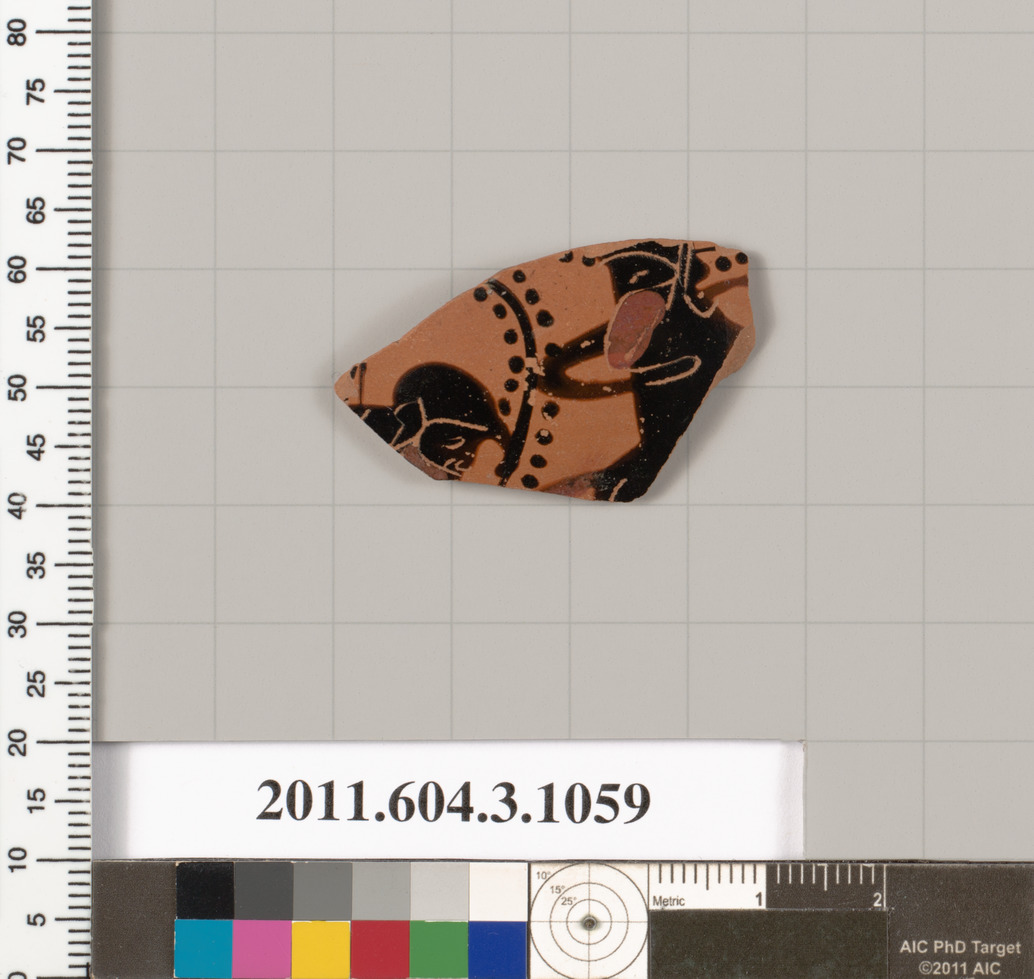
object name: mastoid fragment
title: Terracotta fragment of a mastoid (drinking cup with narrow base)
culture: greek, attic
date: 534-468 BCE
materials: terracotta